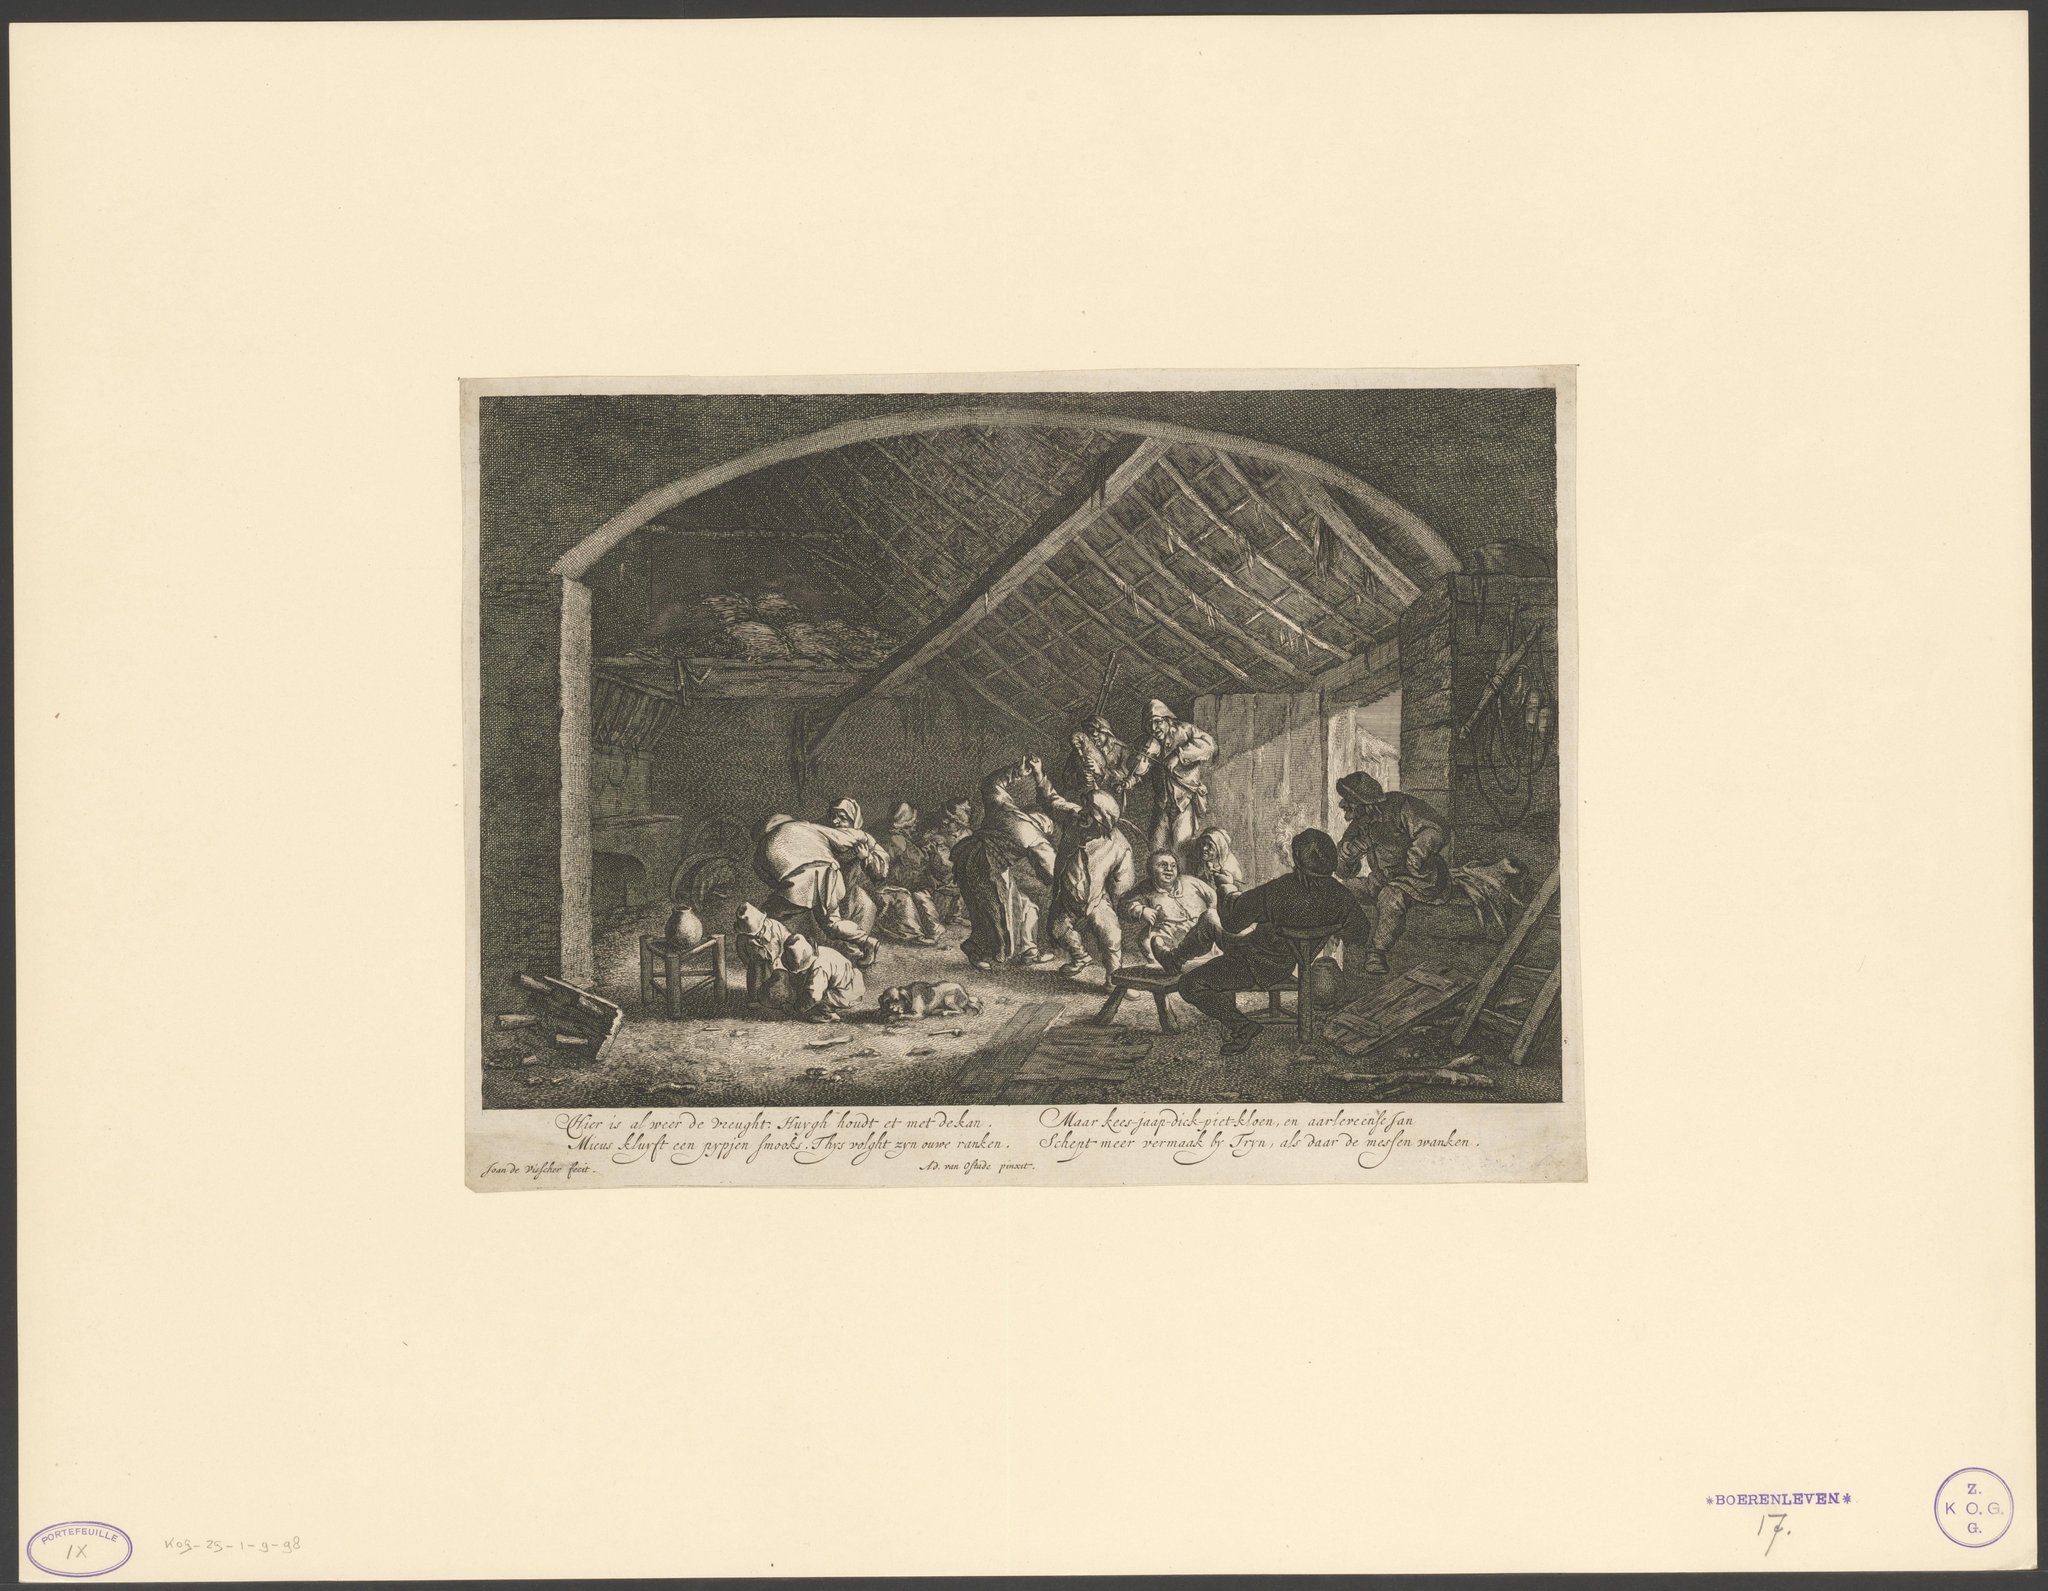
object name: print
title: Volksdans in een schuur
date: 1643-1701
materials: paper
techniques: engraving, etching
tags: violin, fiddle, pipe ~ tobacco, group dancing, tobacco, hotel, hostelry, inn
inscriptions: stamp, collector's mark: Lugt 1641, collector's mark: Lugt 1641, stamp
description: Onderaan een vierregelig vers in twee kolommen. Onderwerpsrubrieken binnen de Atlas Zeden en Gewoonten: Handel, nijverheid en verkeer, Boerenleven.